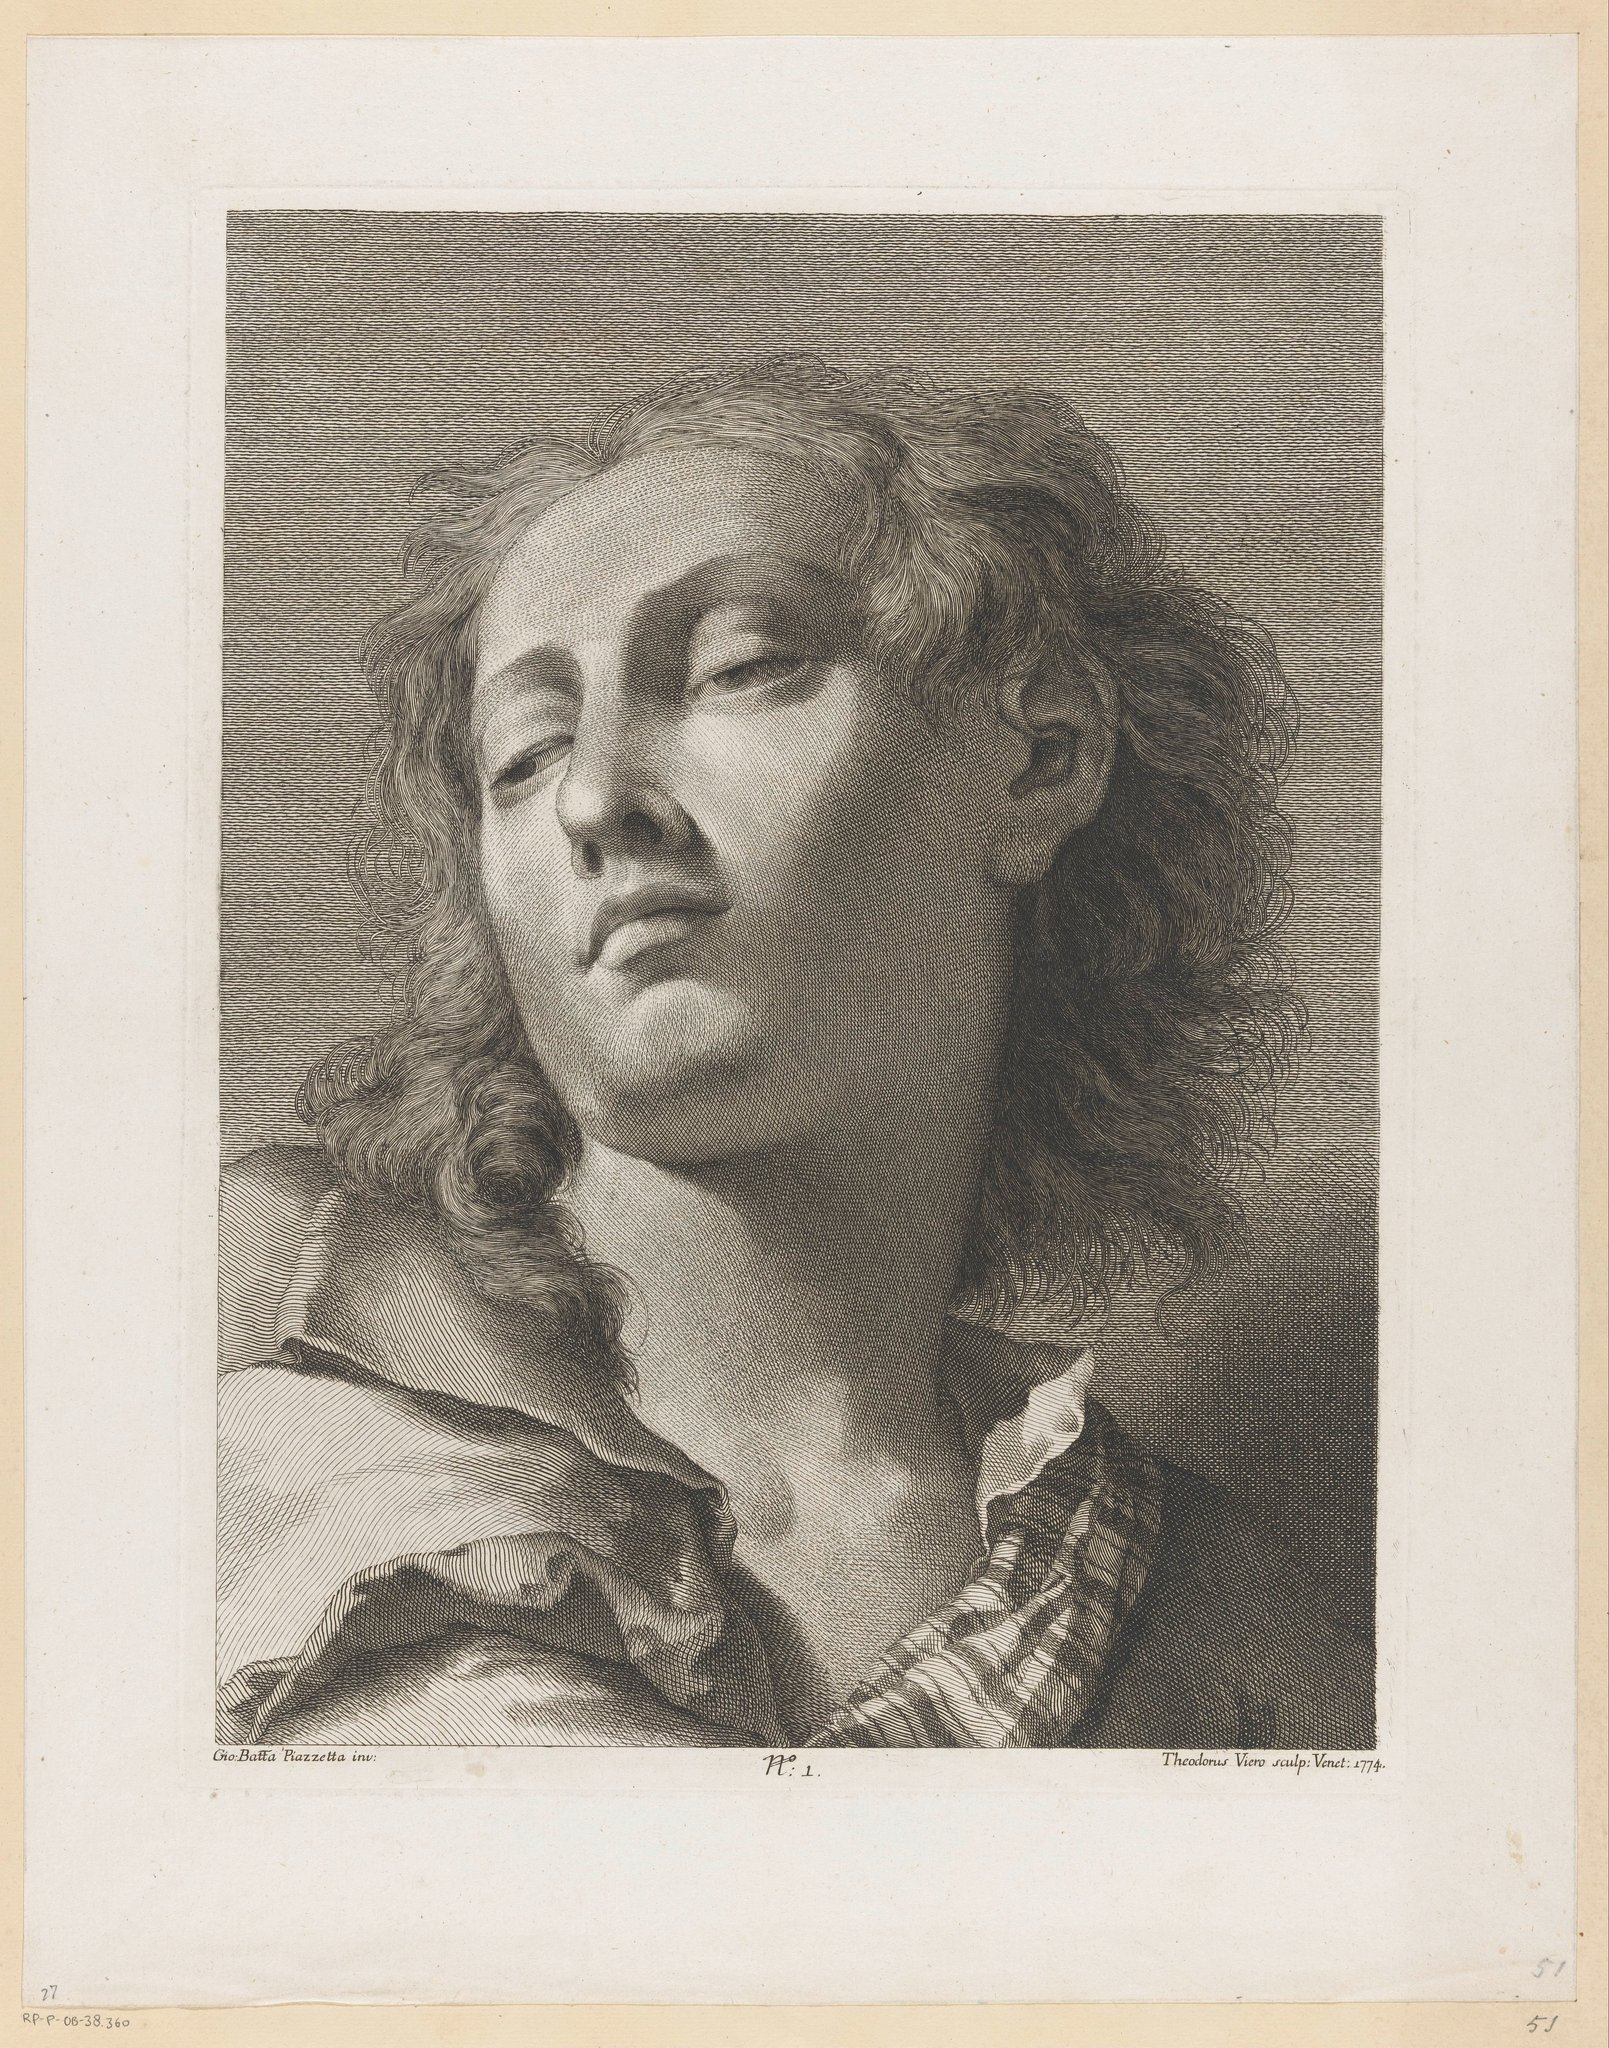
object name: print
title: Hoofd van een jongeman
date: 1774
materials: paper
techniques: engraving, etching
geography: italy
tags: youth, adolescent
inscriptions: collector's mark: Lugt 240